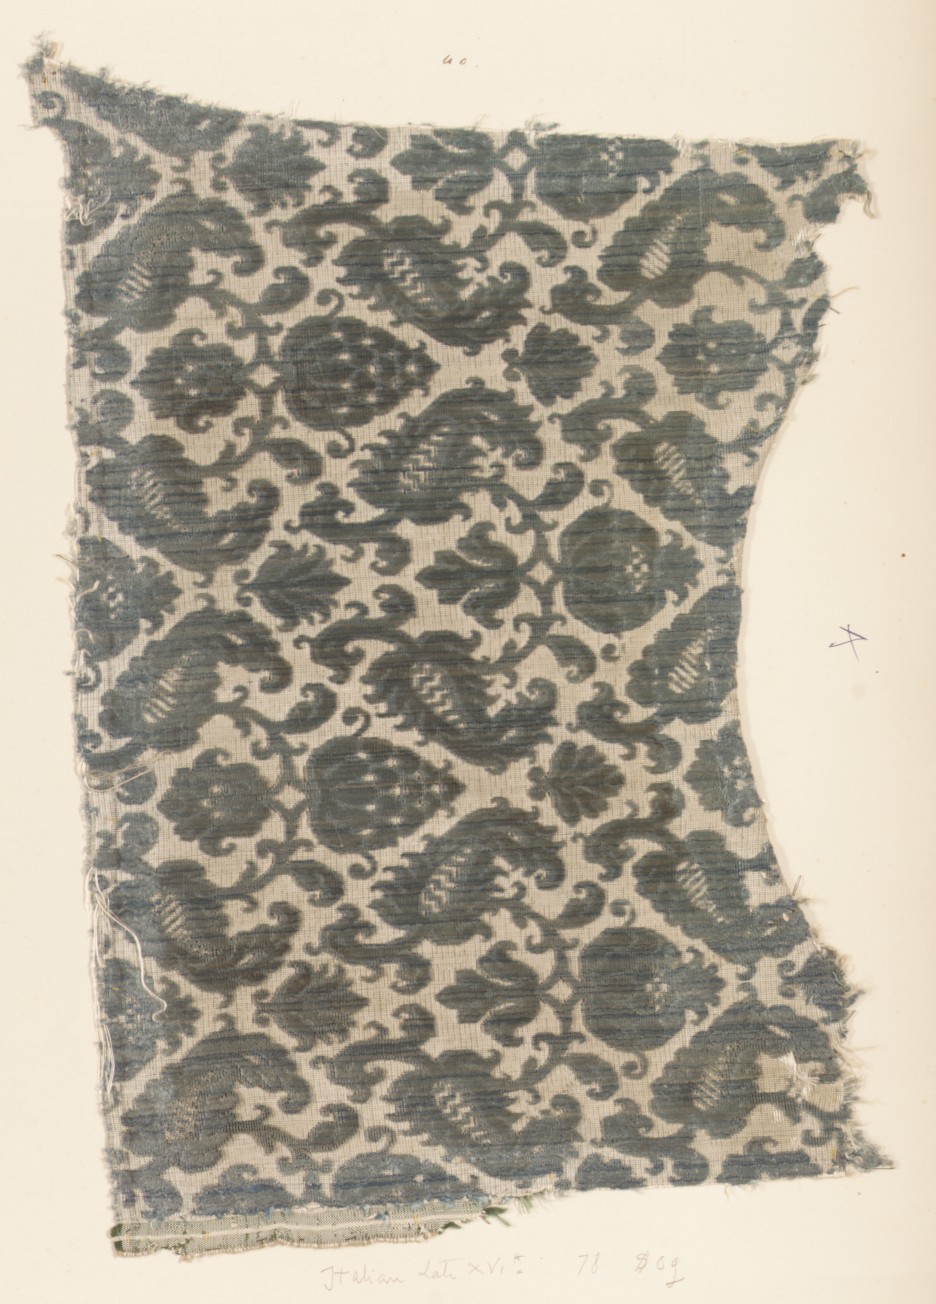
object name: fragment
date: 1567-1700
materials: metal thread, silk